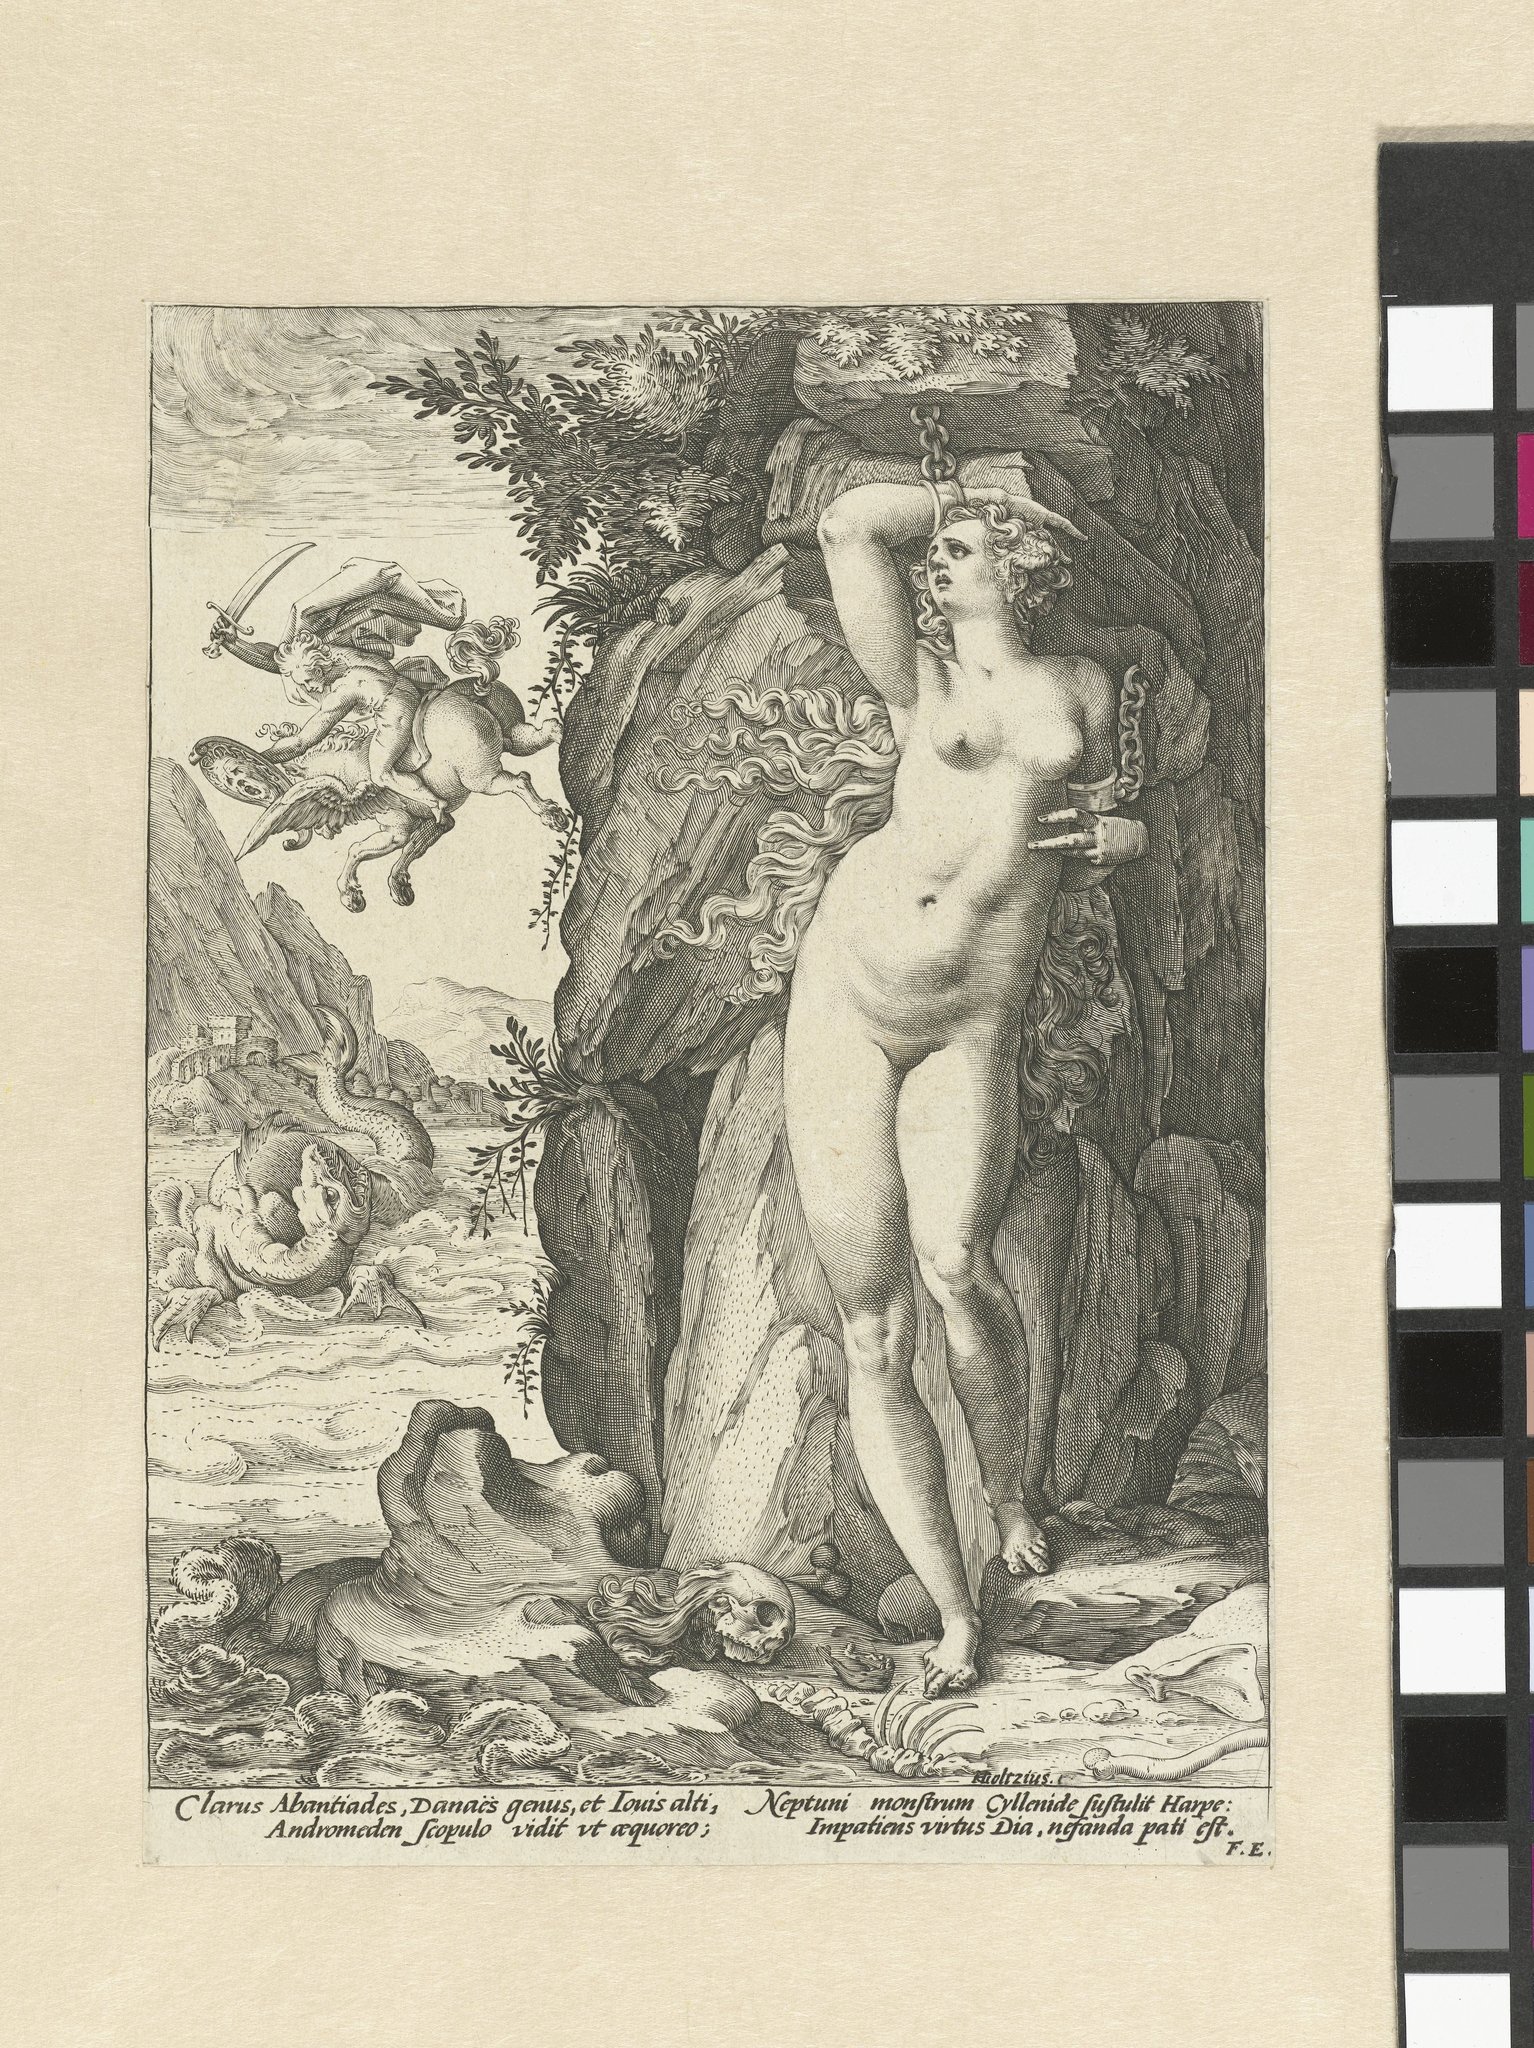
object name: print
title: Perseus en Andromeda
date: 1588-1592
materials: paper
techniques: engraving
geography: haarlem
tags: perseus and andromeda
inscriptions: collector's mark: Lugt 240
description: Andromeda aan een rot geketend. Op de achtergrond links verslaat Perseus het zeemonster dat haar bedreigt. Onder de voorstelling vier regels Latijn.